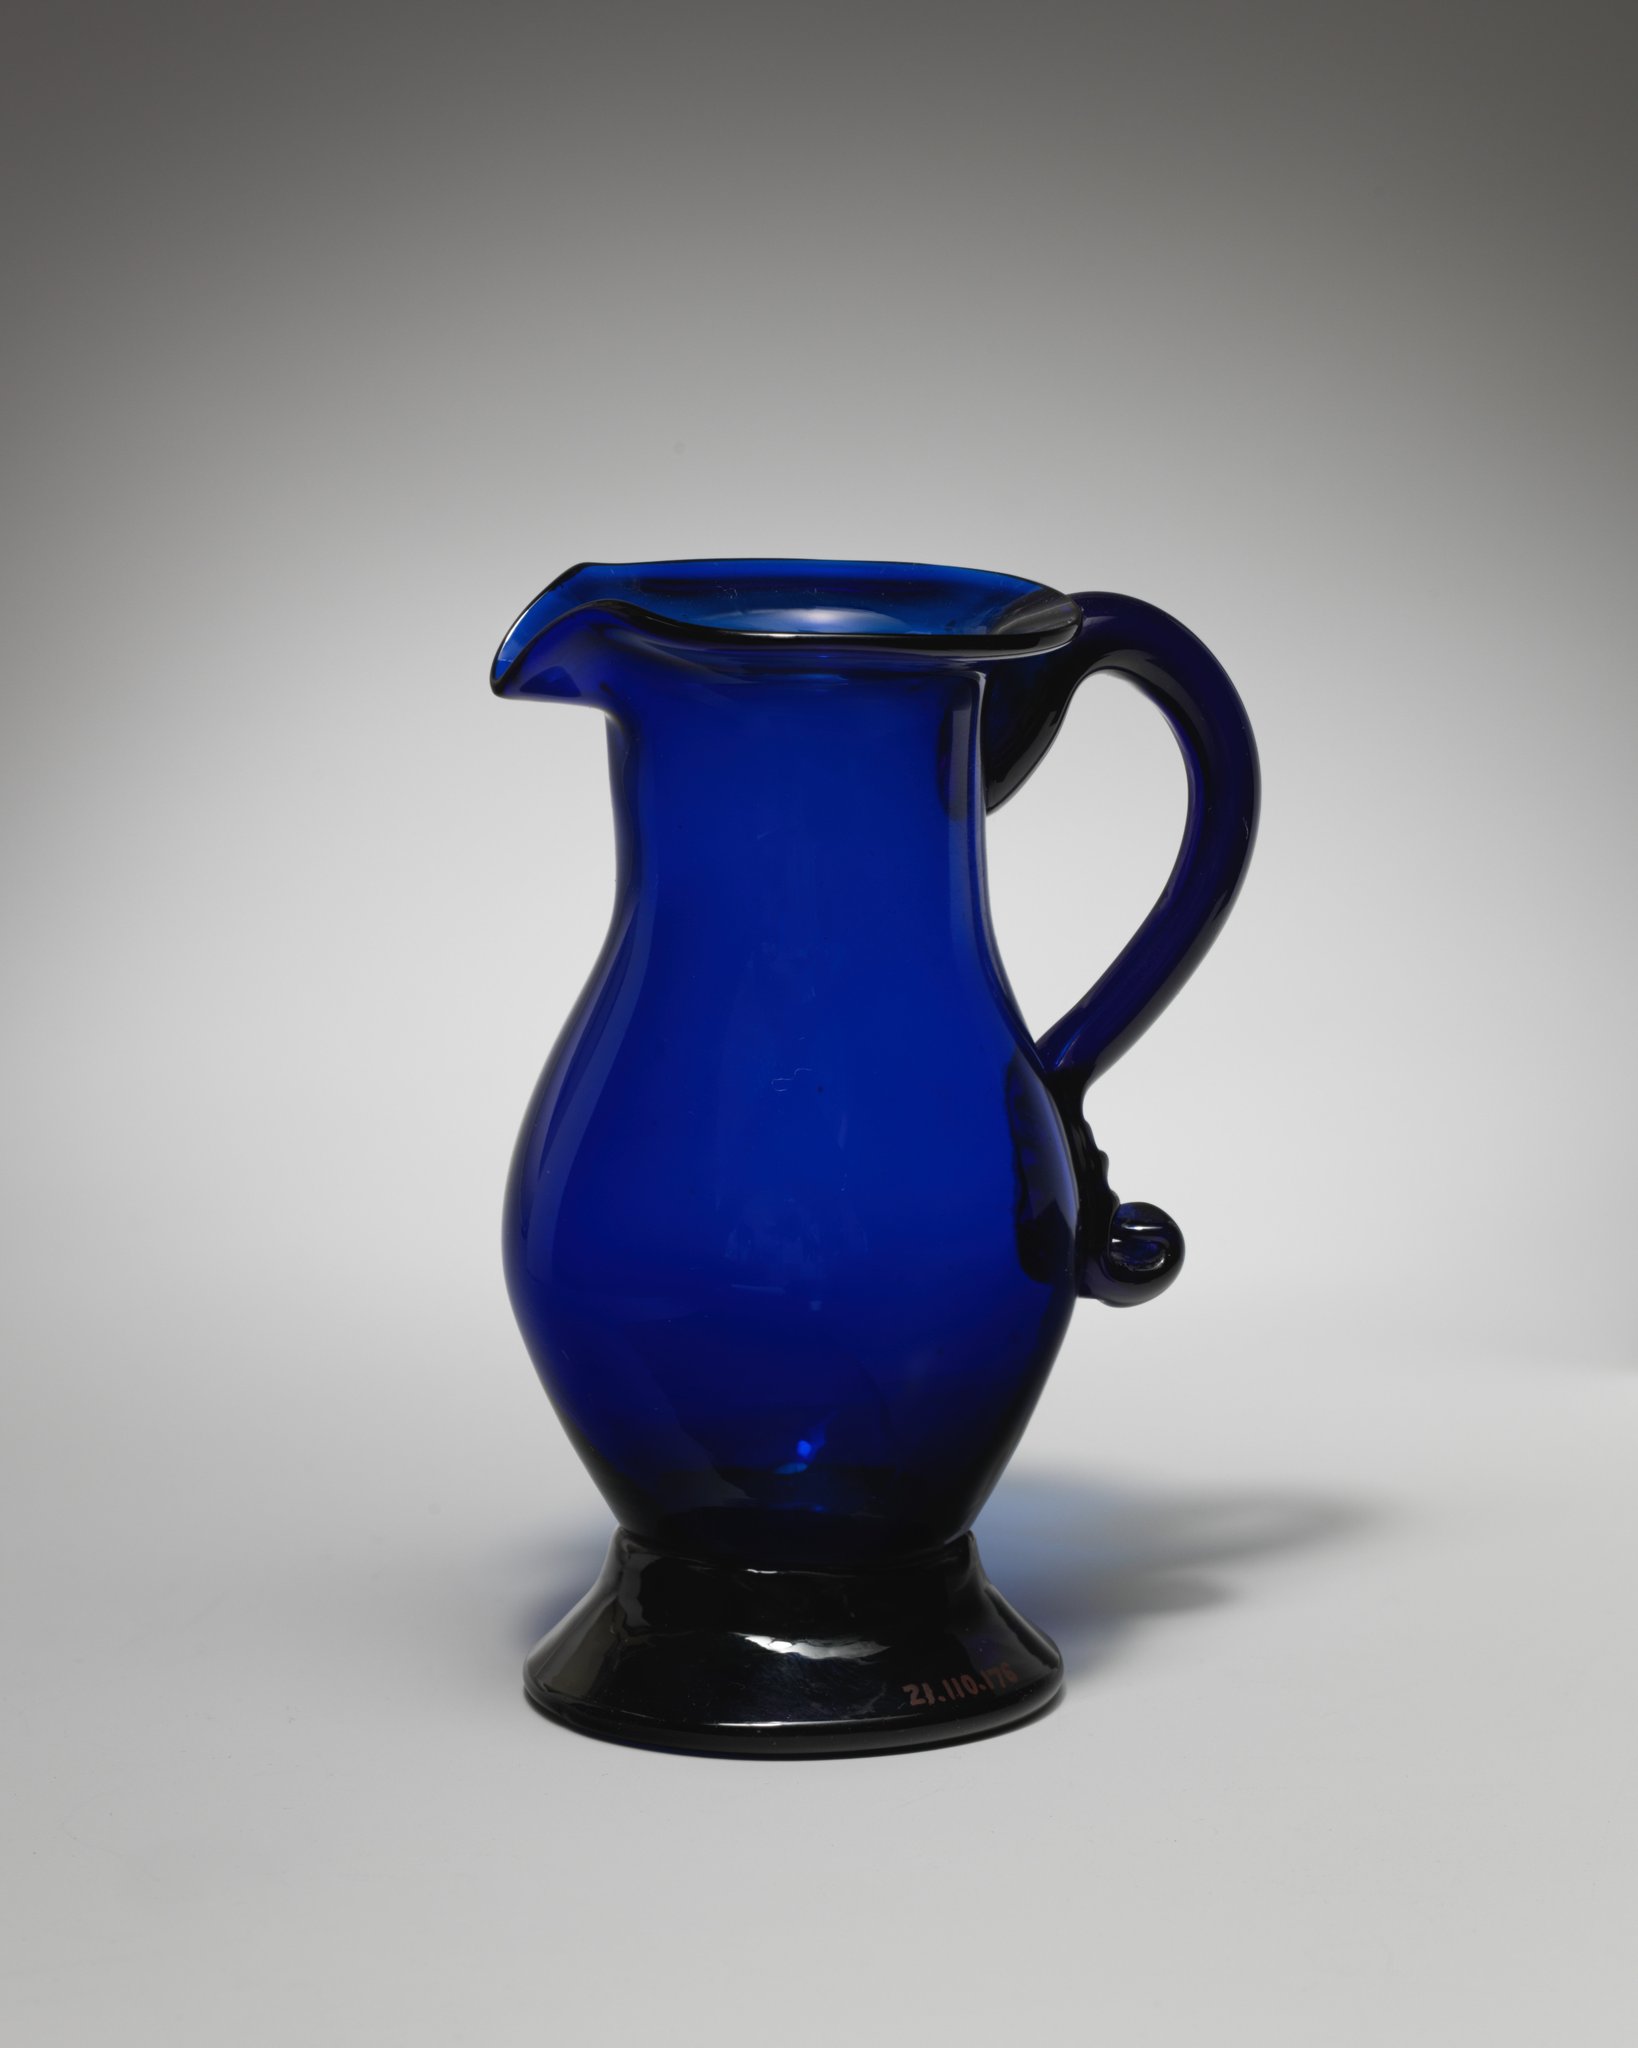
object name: jug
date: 1701-1800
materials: glass